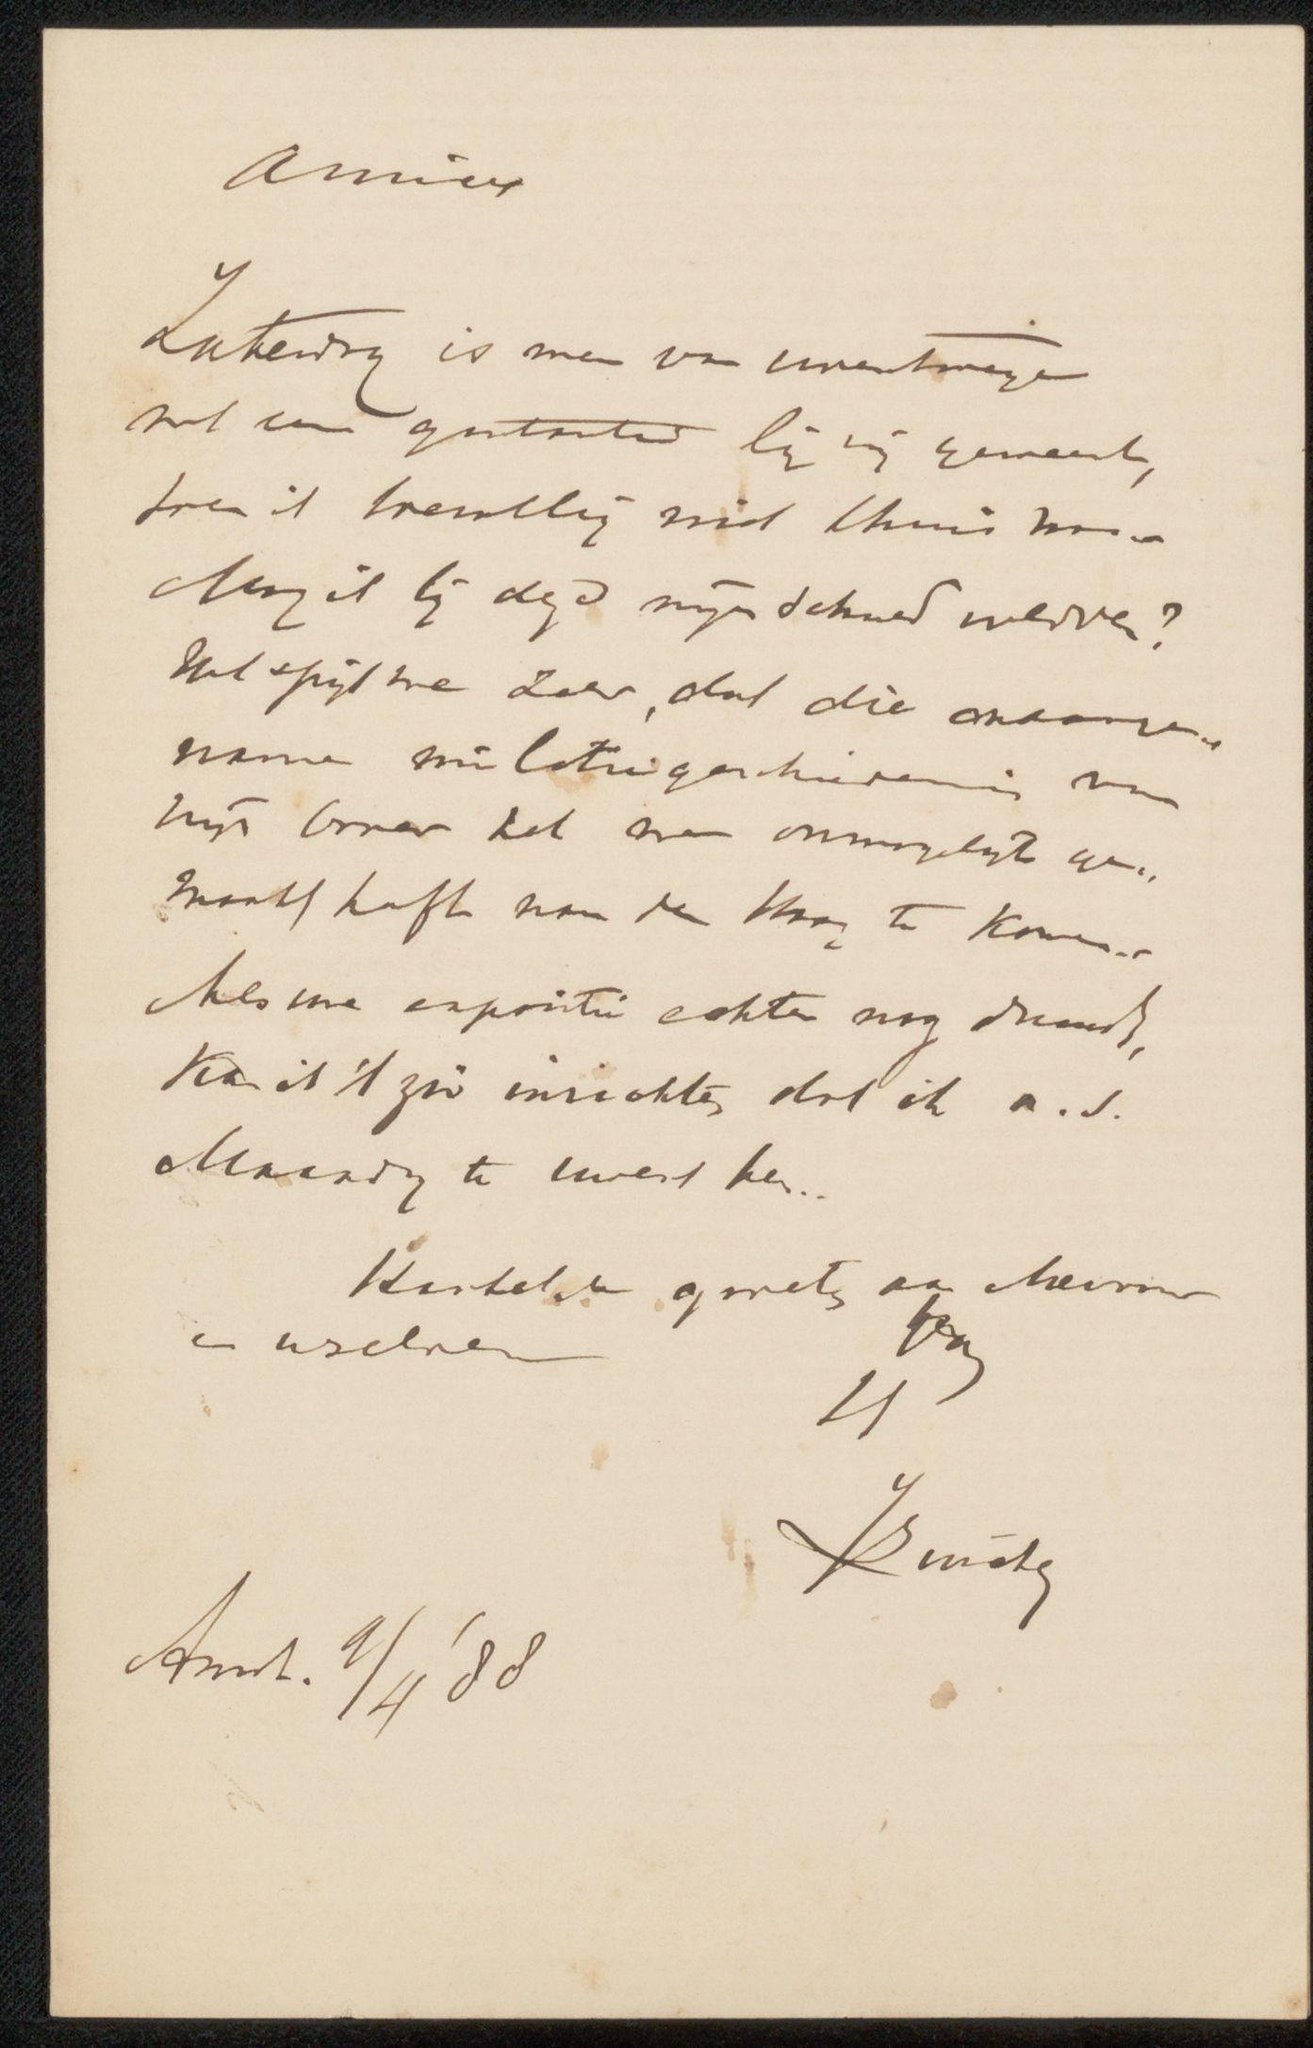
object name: letter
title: Brief aan Philip Zilcken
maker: jan zürcher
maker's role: painter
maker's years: 1851-1905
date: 1888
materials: ink, paper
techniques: pen, writing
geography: amsterdam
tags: draughtsman, philip zilcken, family life, exhibition ~ art, the hague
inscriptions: collector's mark: ‘RPK’